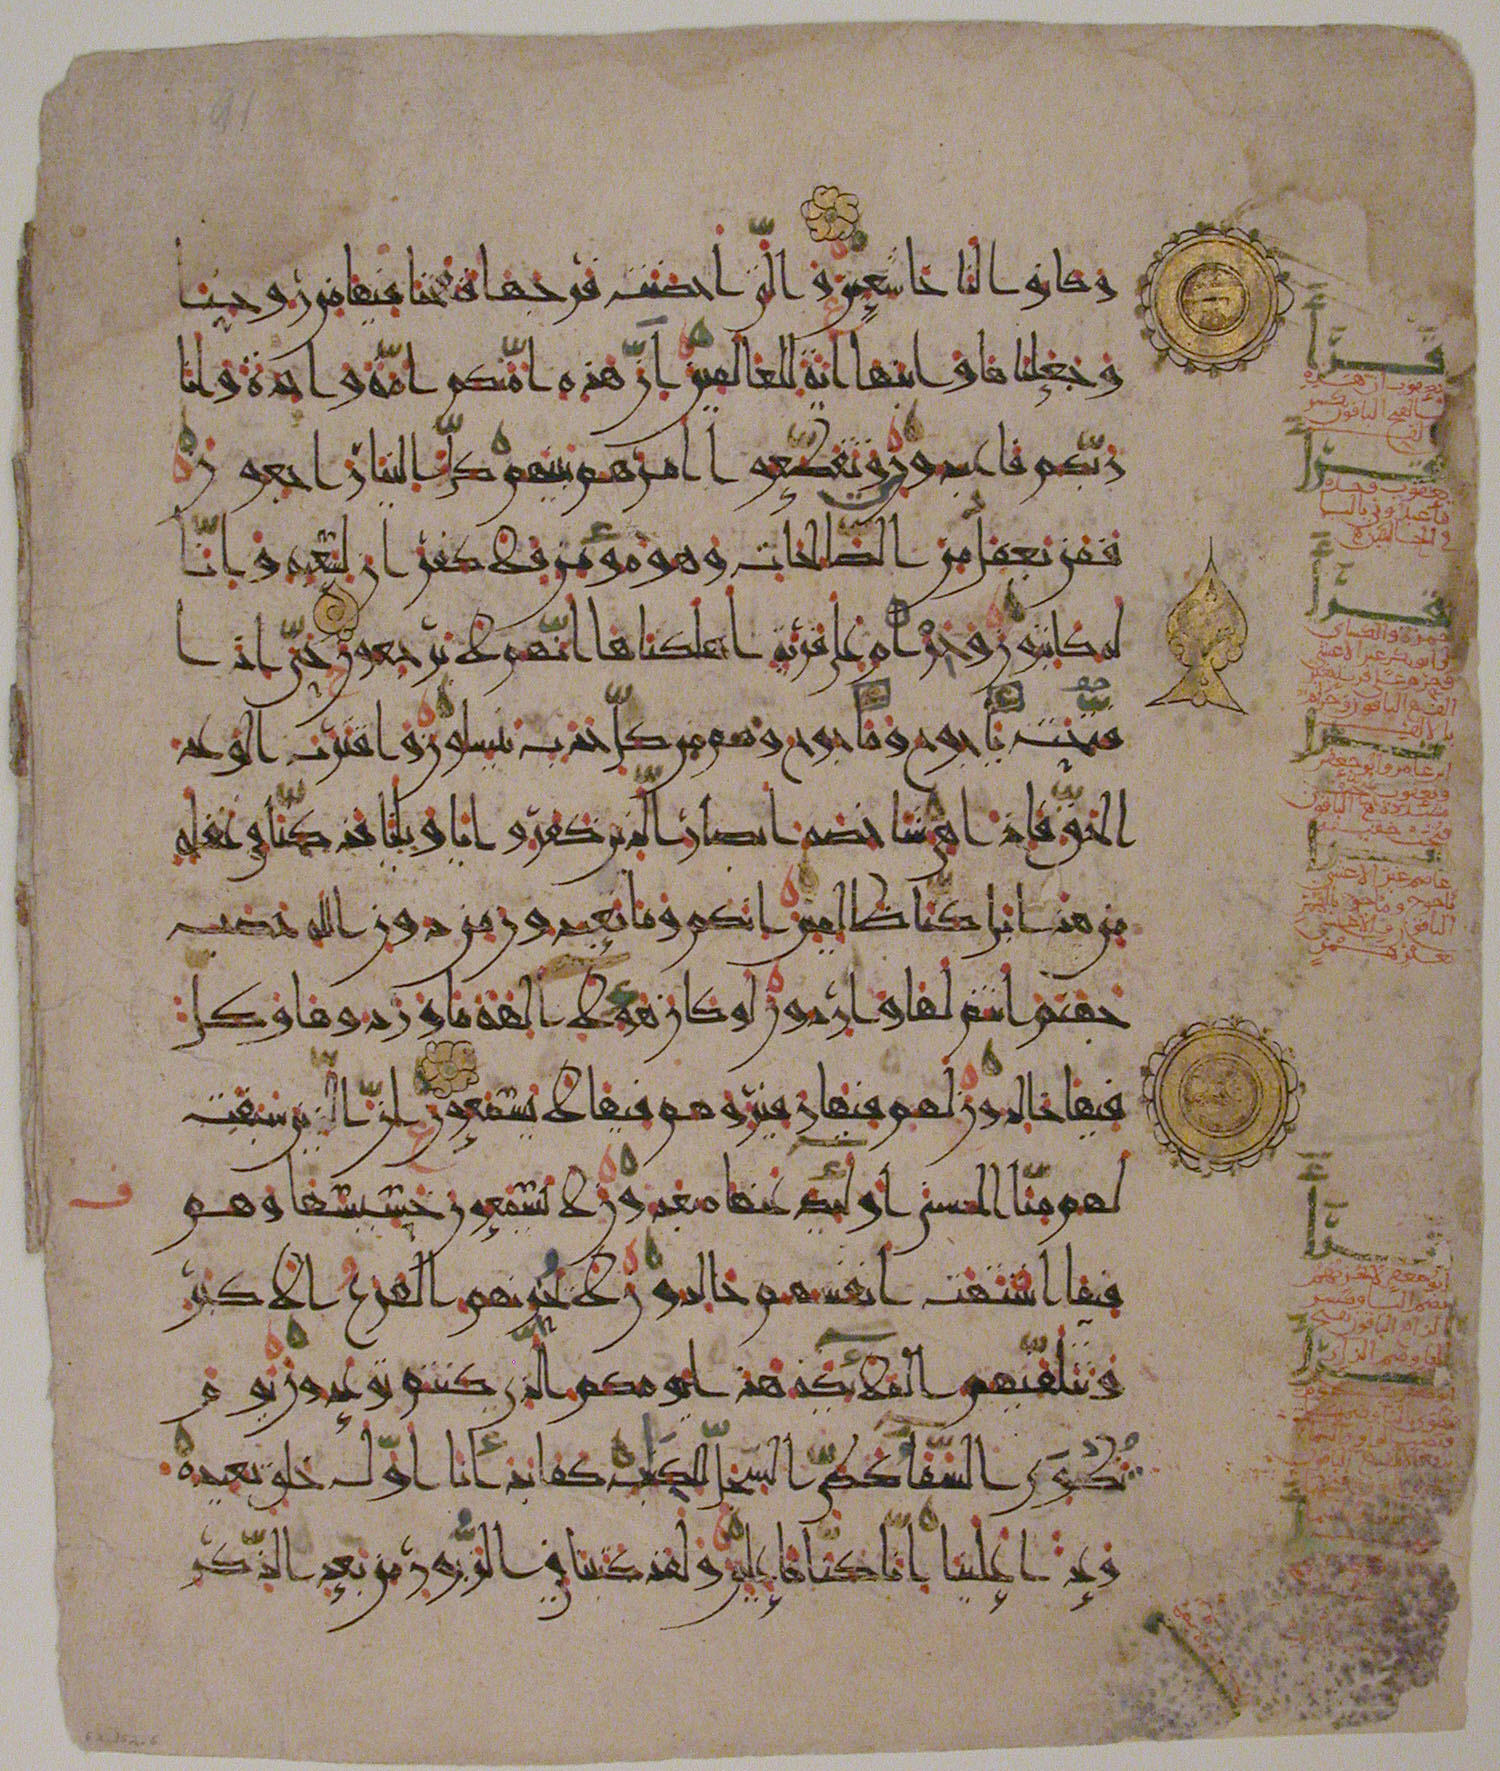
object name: folio from a non illustrated manuscript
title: Folio from a Qur'an Manuscript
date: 951-1000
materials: gold, ink, paper, watercolor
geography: islamic lands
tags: qur'an,calligraphy